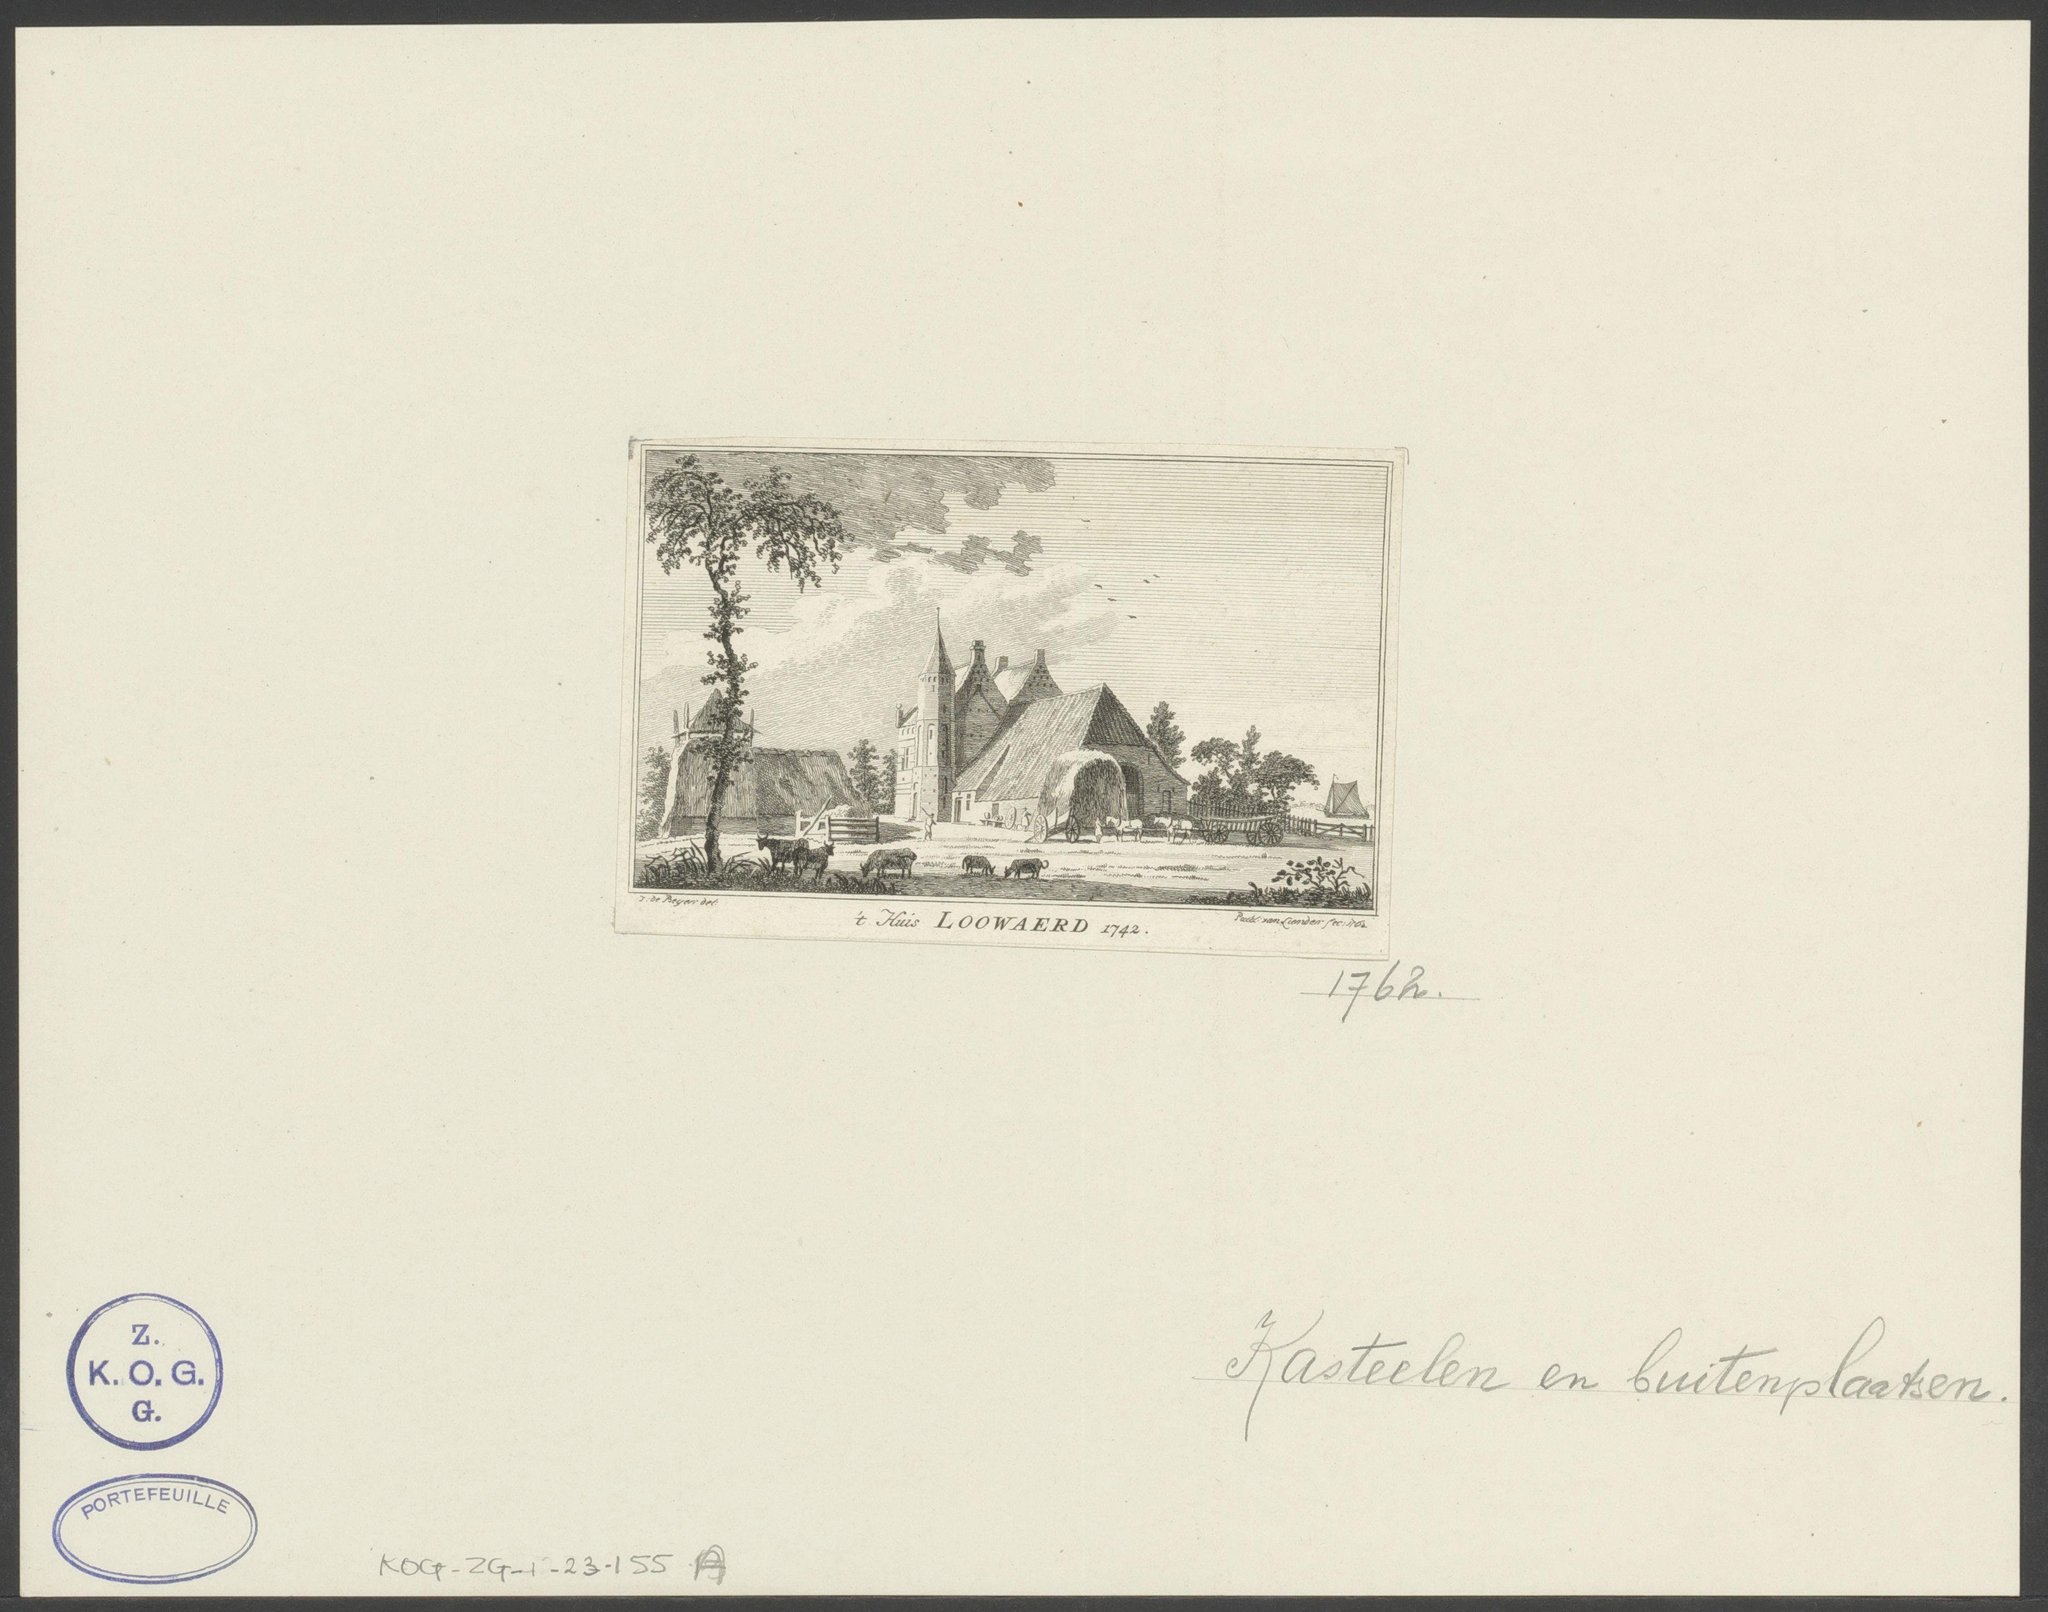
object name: print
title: 't Huis Loowaerd 1742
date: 1762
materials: paper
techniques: etching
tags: parts of church exterior and annexes: chapel - qq - small church, chapel, farm or solitary house in landscape, country-house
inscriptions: collector's mark: Lugt 1641, stamp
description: De prent maakt deel uit van een 100-delige serie met gezichten op dorpen en steden te Kleef. Onderwerpsrubrieken binnen de Atlas Zeden en Gewoonten: Zeden en gewoonten in Engeren zin, De woning, Kastelen en buitenplaatsen.